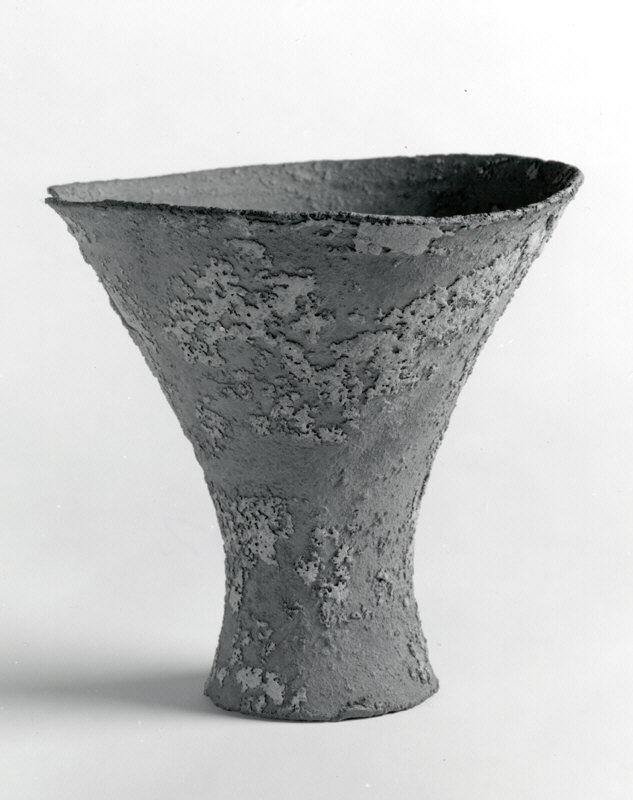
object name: vessel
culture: bactria-margiana archaeological complex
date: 2333-1668 BCE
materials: silver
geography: bactria-margiana